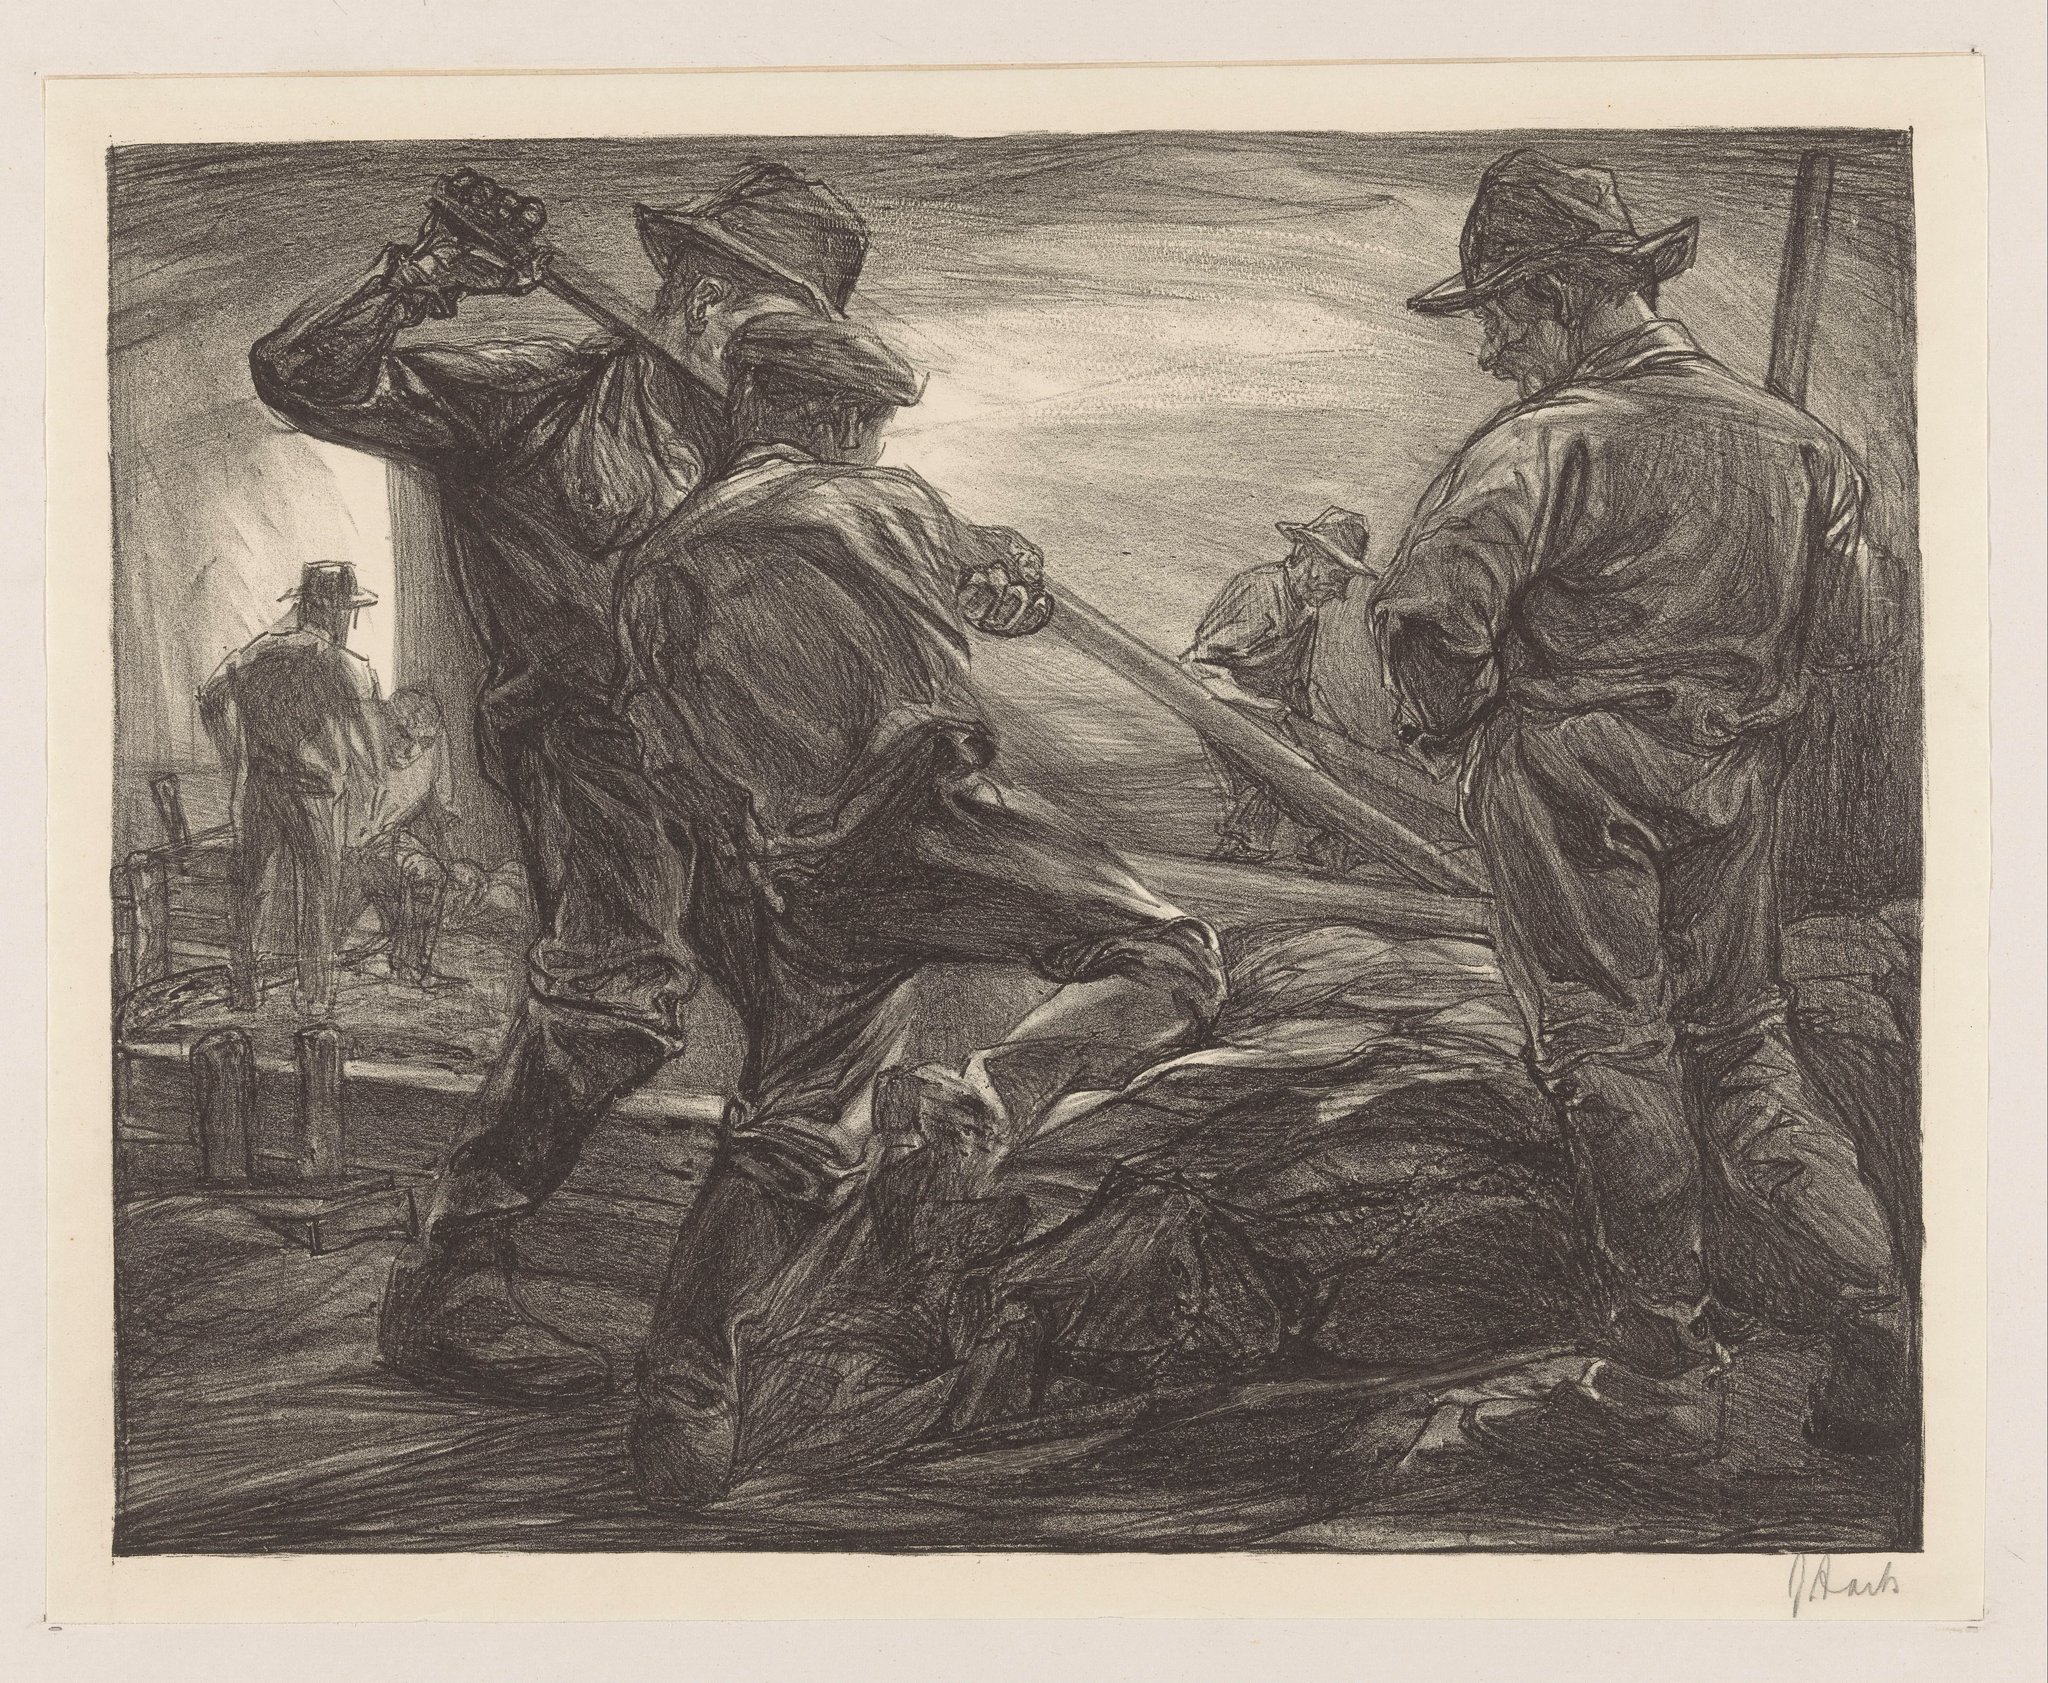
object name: print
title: Dijkwerkers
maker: johannes josephus aarts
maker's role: draughtsman, print maker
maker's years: 1871-1934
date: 1881-1931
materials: paper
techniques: lithograph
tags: working class, labourers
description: Twee mannen kijken toe hoe een derde man met een staaf aan het wrikken is. Op de achtergrond zijn nog drie mannen aan het werk.